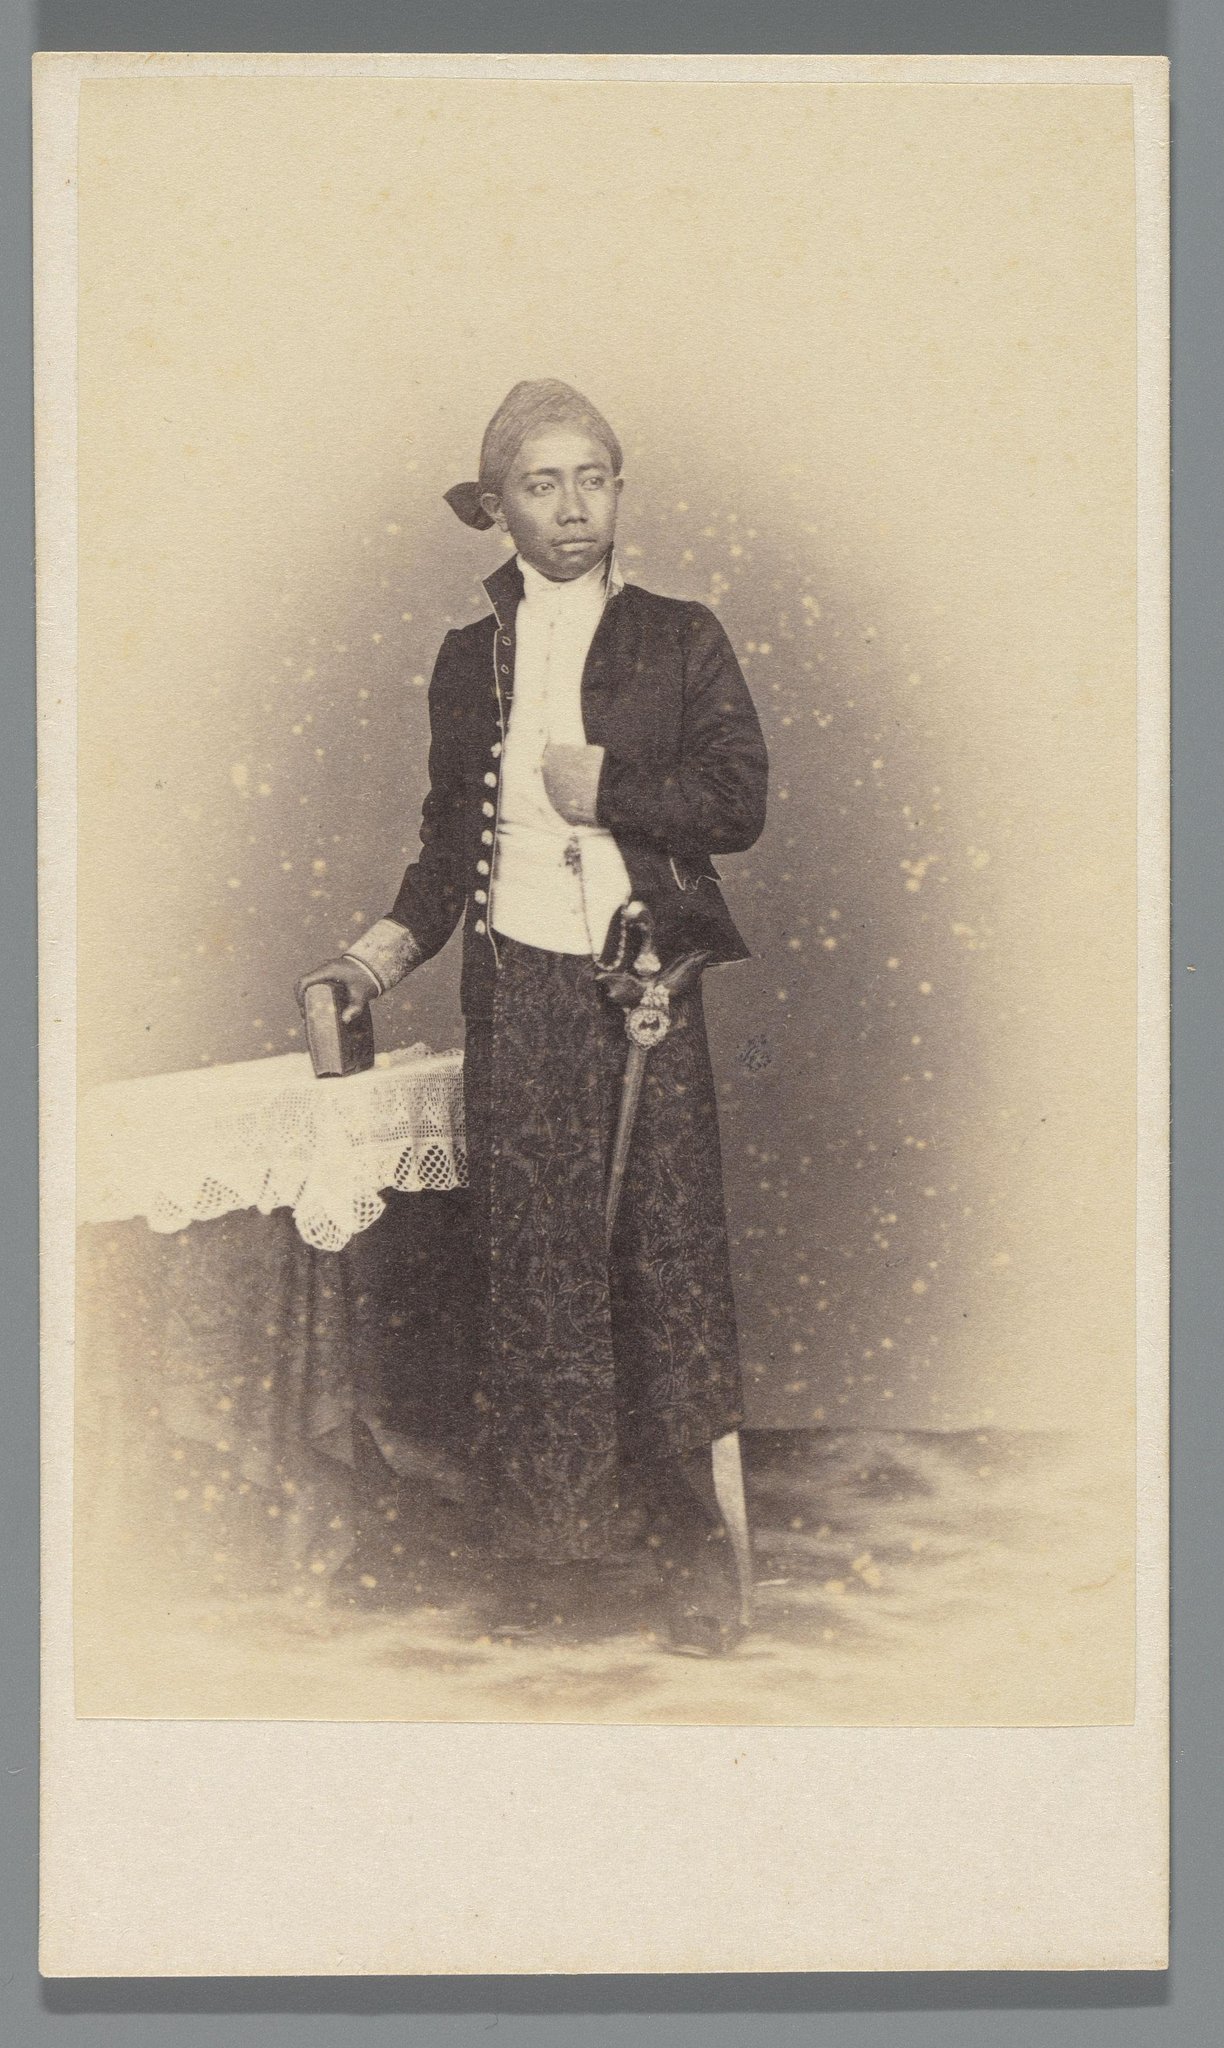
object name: carte de visite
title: Portret van onbekende staande man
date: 1860-1910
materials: cardboard, photographic support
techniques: albumen print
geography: java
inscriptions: name: ‘WOODBURY & PAGE / PHOTOGRAPHERS / JAVA.’, inscription, number: ‘B1’